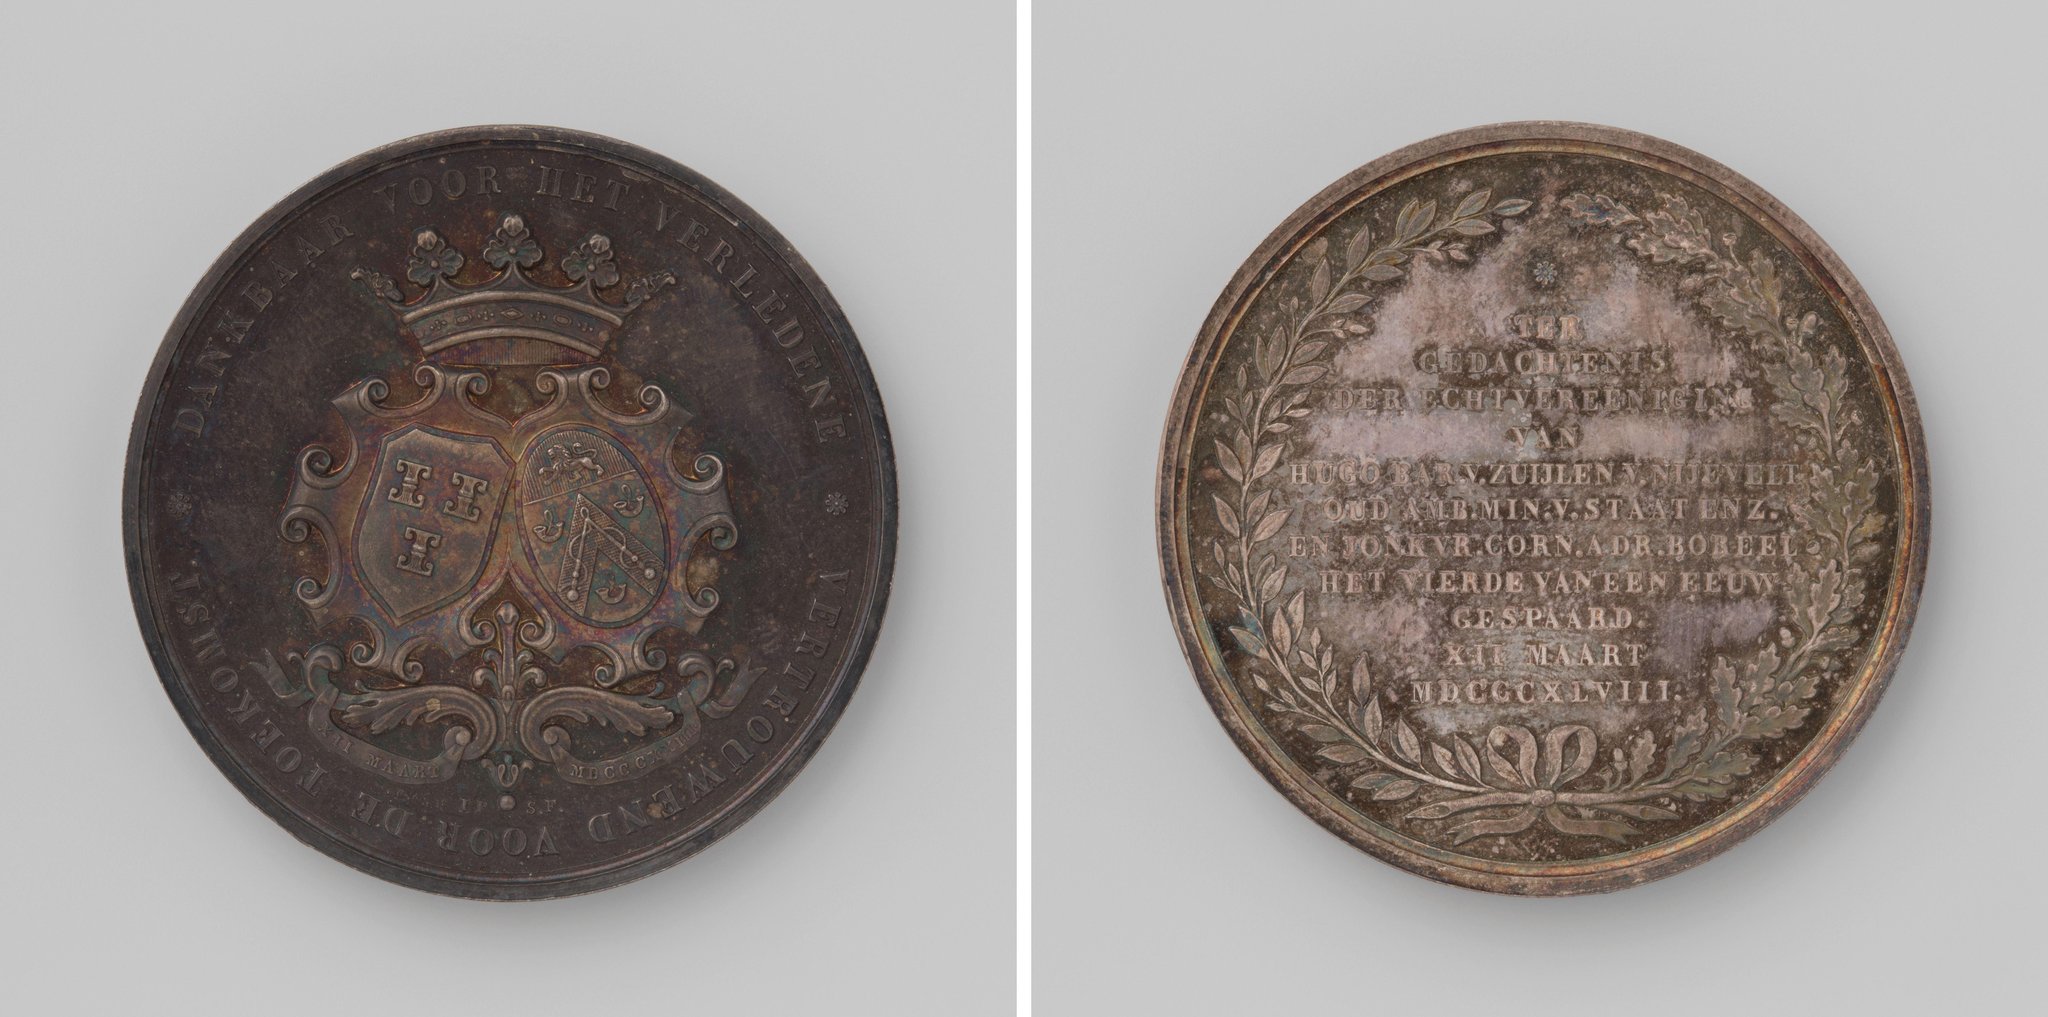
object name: marriage medal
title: Vijfentwintigjarig huwelijk van Hugo, baron van Zuijlen van Nijevelt en jonkvrouwe Cornelia Adriana Boreel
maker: johannis petrus schouberg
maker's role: die cutter, draughtsman, print maker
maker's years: 1798-1864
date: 1848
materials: silver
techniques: striking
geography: utrecht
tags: hugo baron van zuylen van nijevelt, cornelia adriana boreel (jvr.)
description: Zilveren penning. Voorzijde: twee wapenschilden onder een kroon binnen omschrift. Keerzijde: opschrift binnen tot krans samengebonden olijf- en eikekrans.